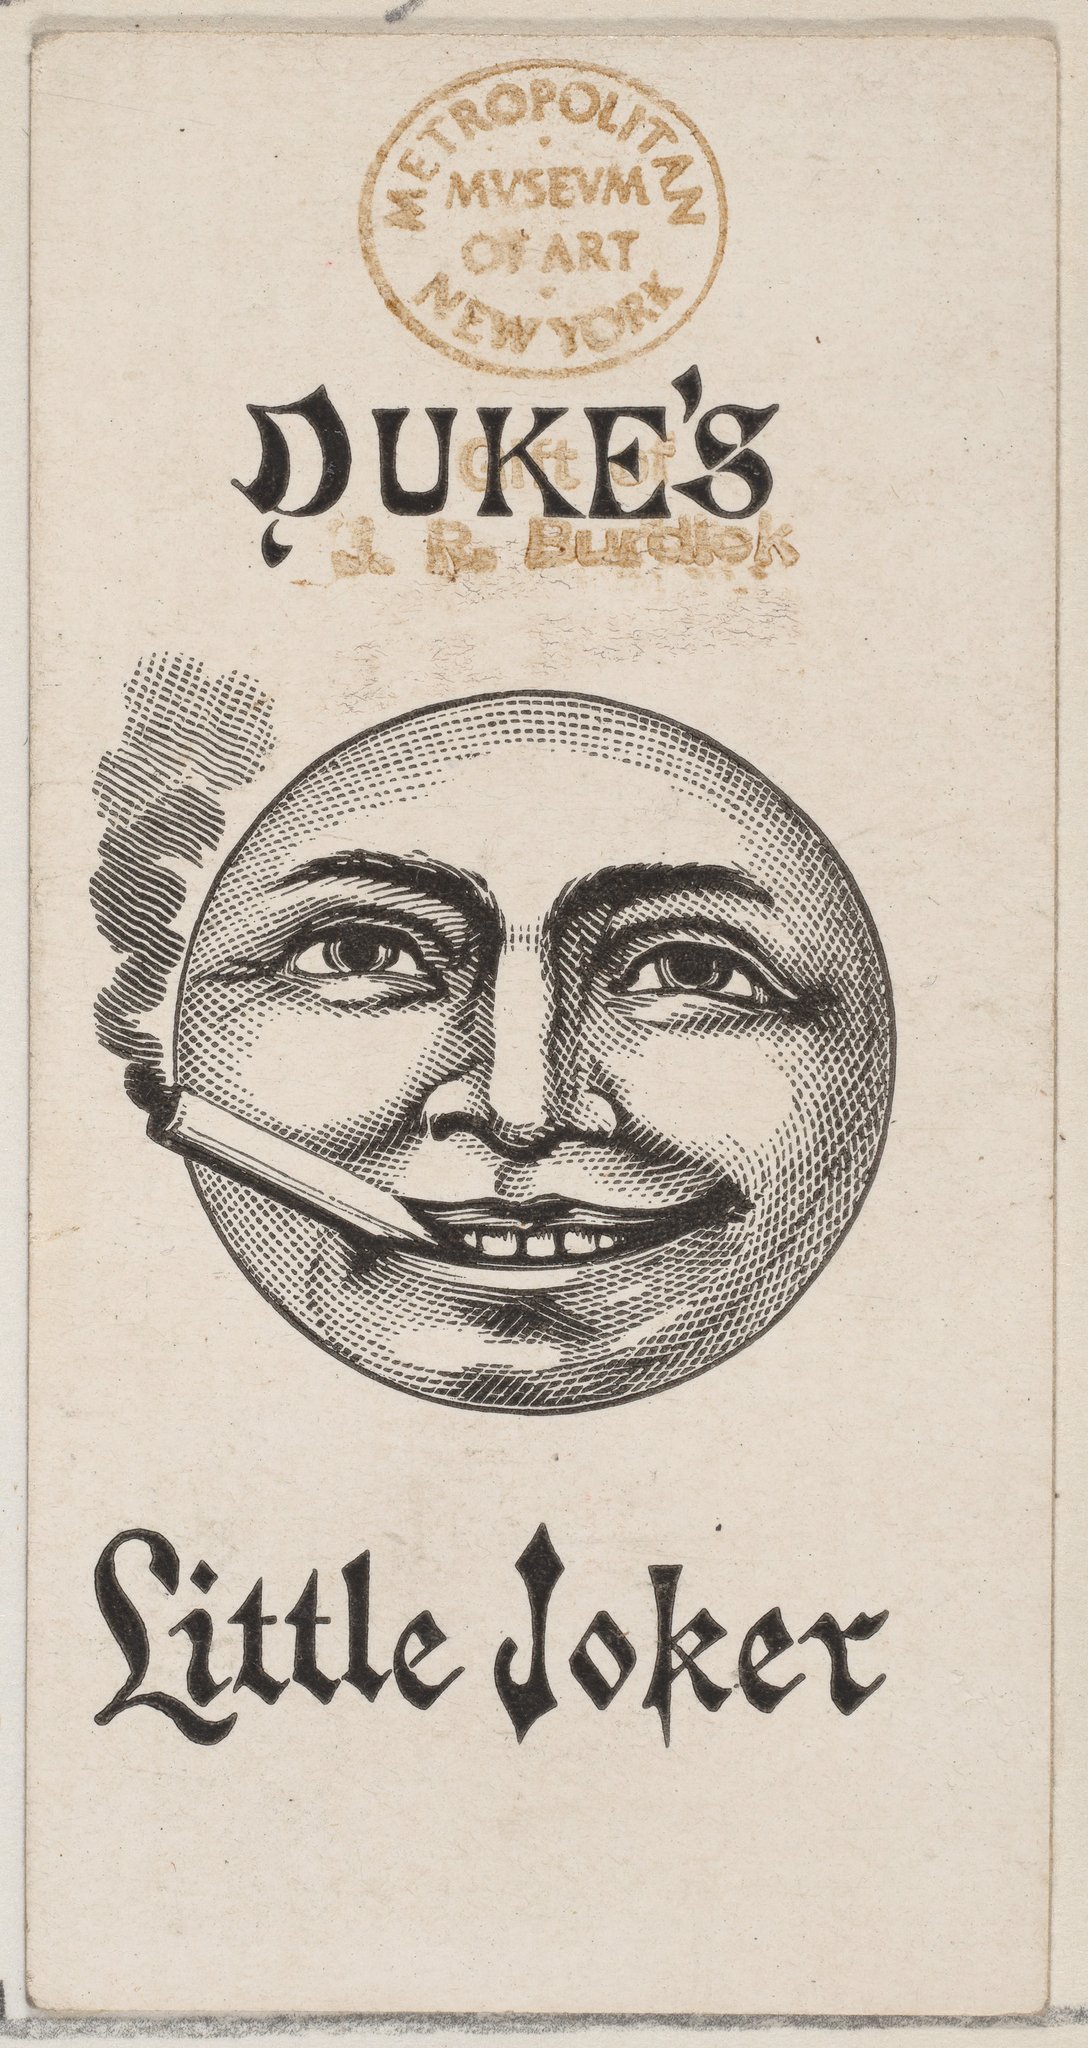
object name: print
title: Duke's Little Joker, from the Playing Cards series (N84) to promote Turkish Cross-Cut Cigarettes for W. Duke, Sons and Co.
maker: w. duke, sons & co.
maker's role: publisher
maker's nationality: american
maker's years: 1870-1920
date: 1888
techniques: color lithograph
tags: playing cards